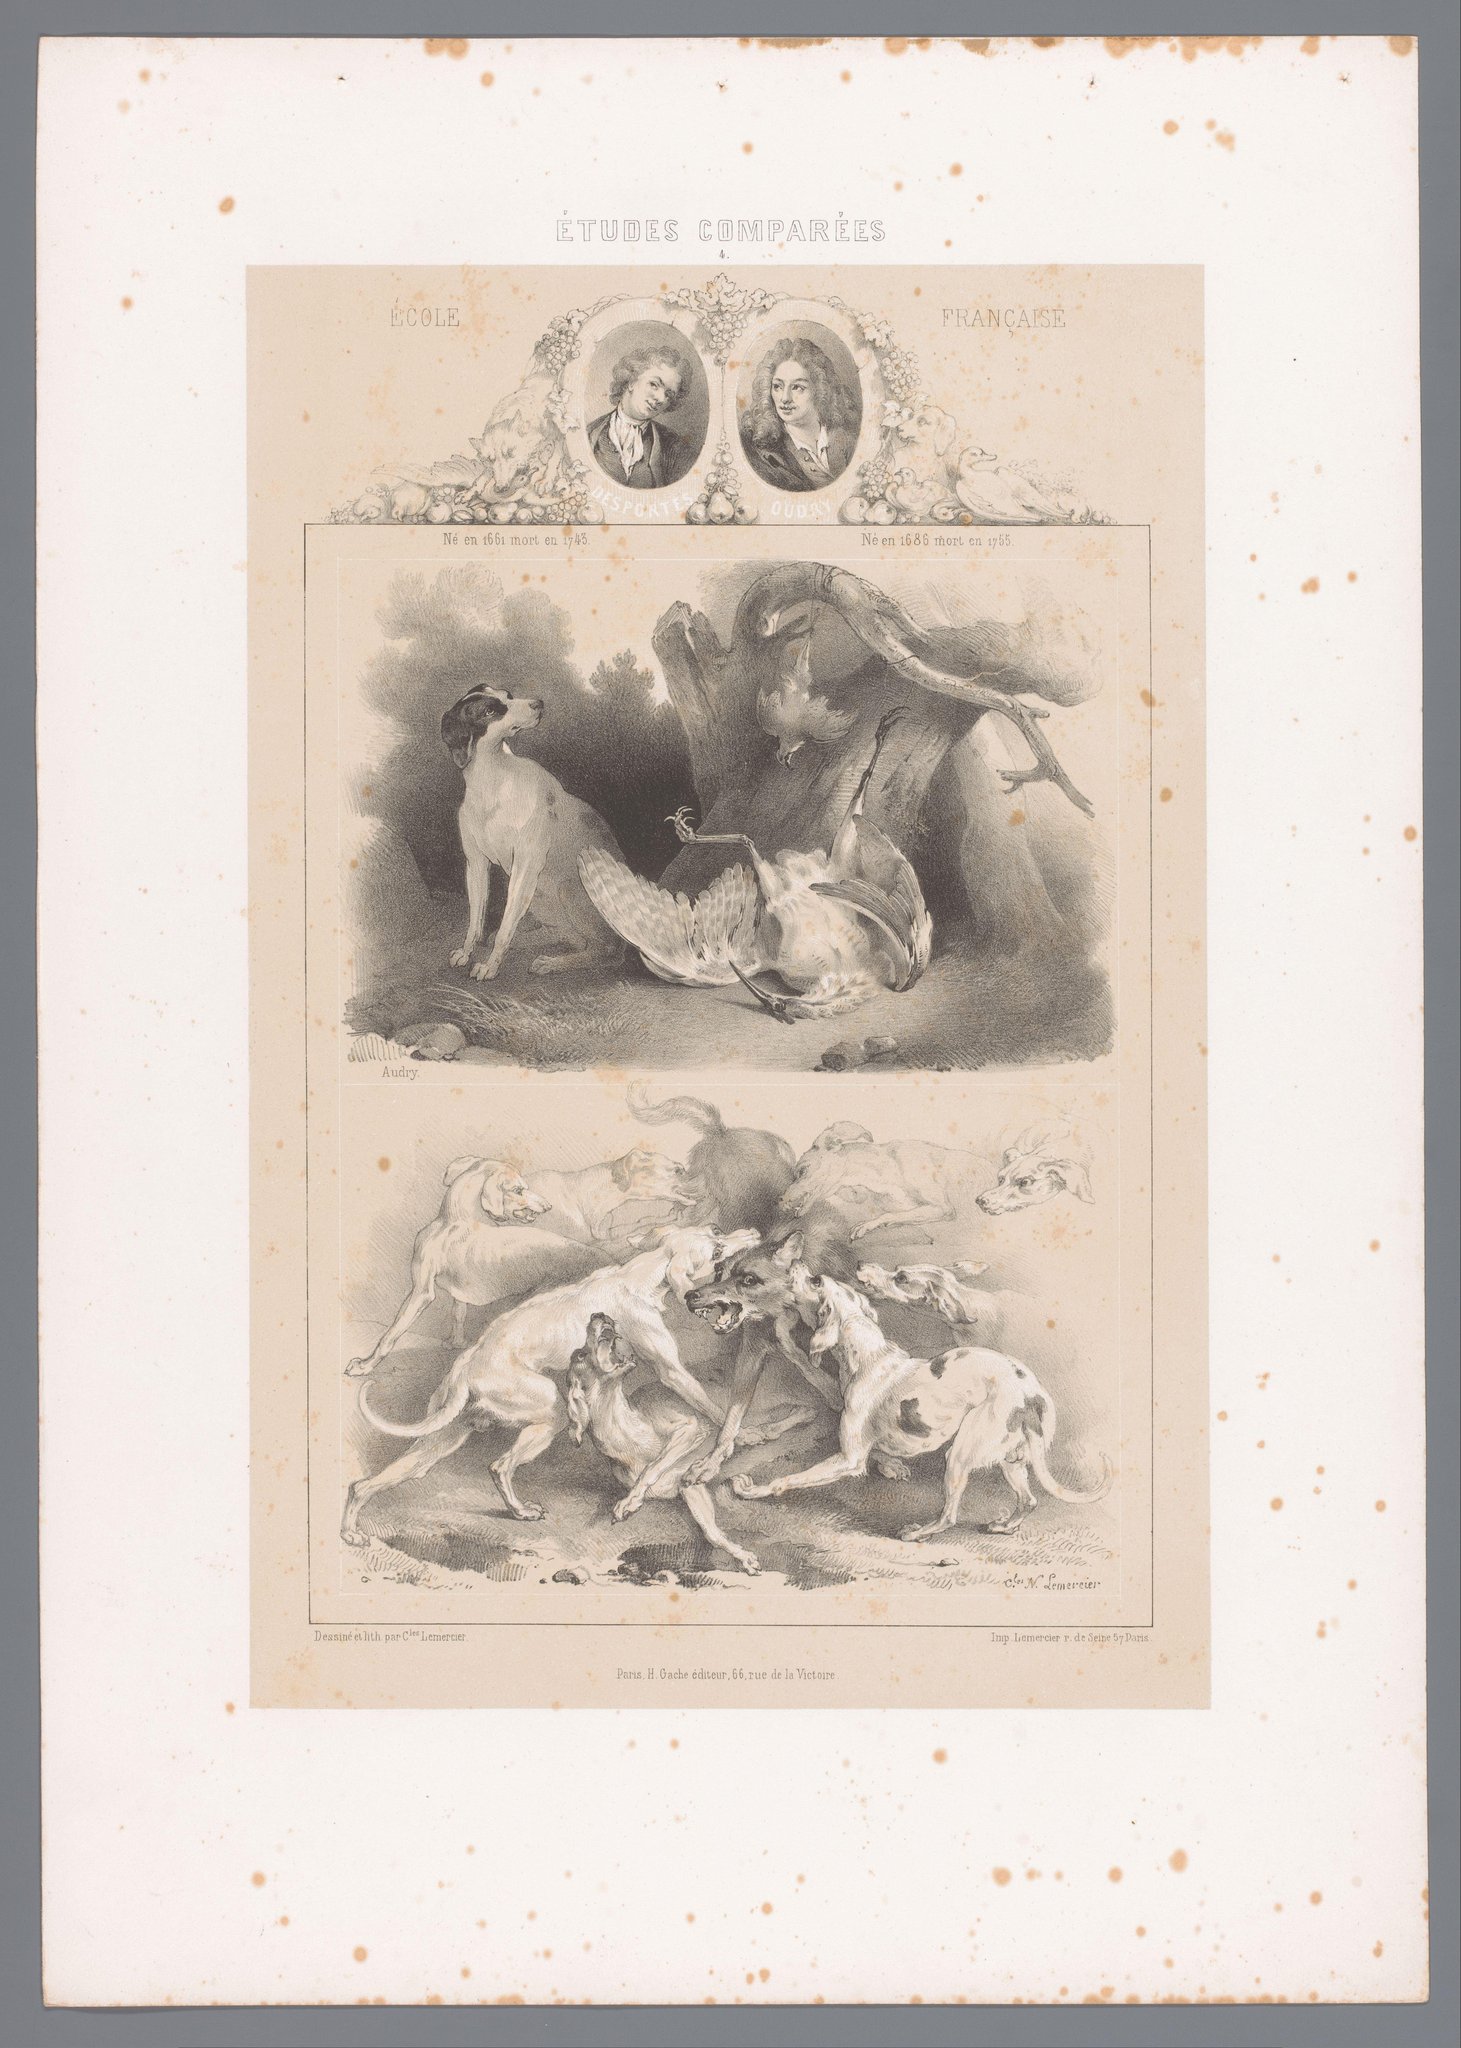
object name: print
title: Études comparées des maitres des diverses écoles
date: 1850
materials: paper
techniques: tone lithography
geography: paris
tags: painter, françois desportes, paris, beauvais, print maker, draughtsman, jean-baptiste oudry, historical persons, painting (including book-illumination, miniature-painting)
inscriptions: collector's mark: Lugt 2228a